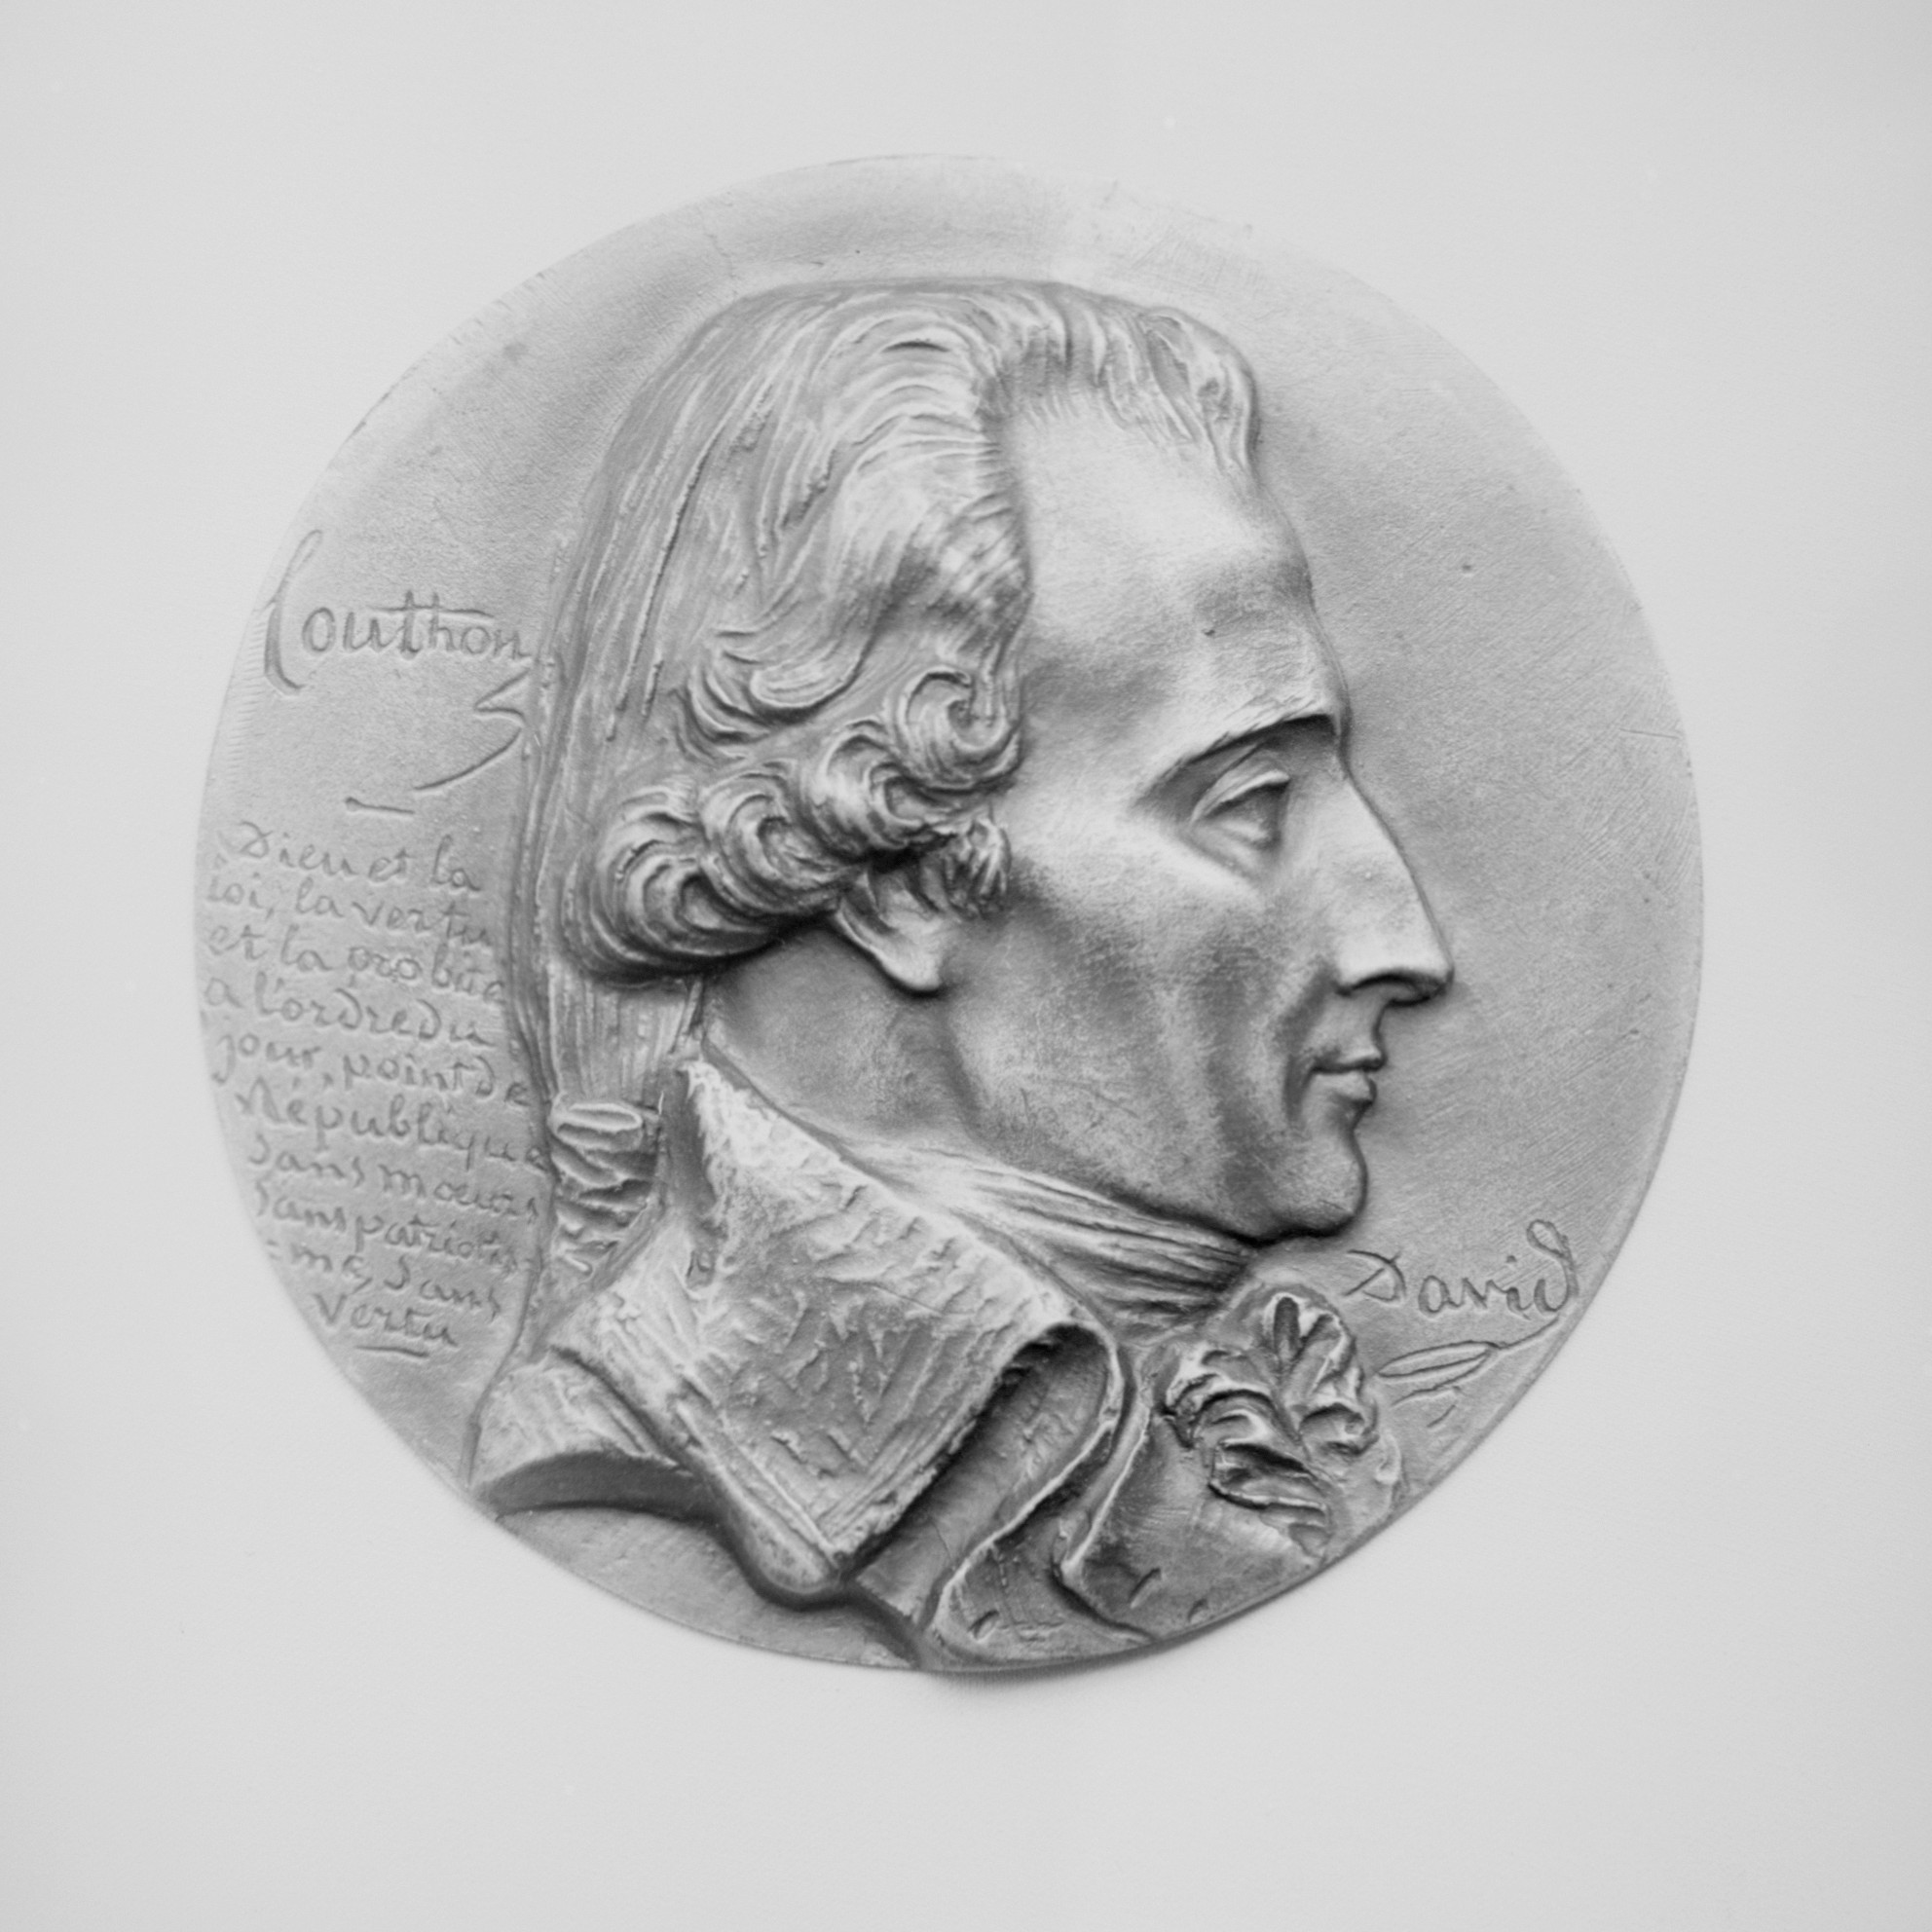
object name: medallion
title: Georges Couthon (1756–1794), Member of the Revolutionary Convention of 1792; one of the Triumvirate with Robespierre and Saint-Just, with whom he was guillotined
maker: pierre jean david d'angers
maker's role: artist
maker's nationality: french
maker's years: 1788-1856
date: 1801-1900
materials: bronze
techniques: casting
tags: men,profiles